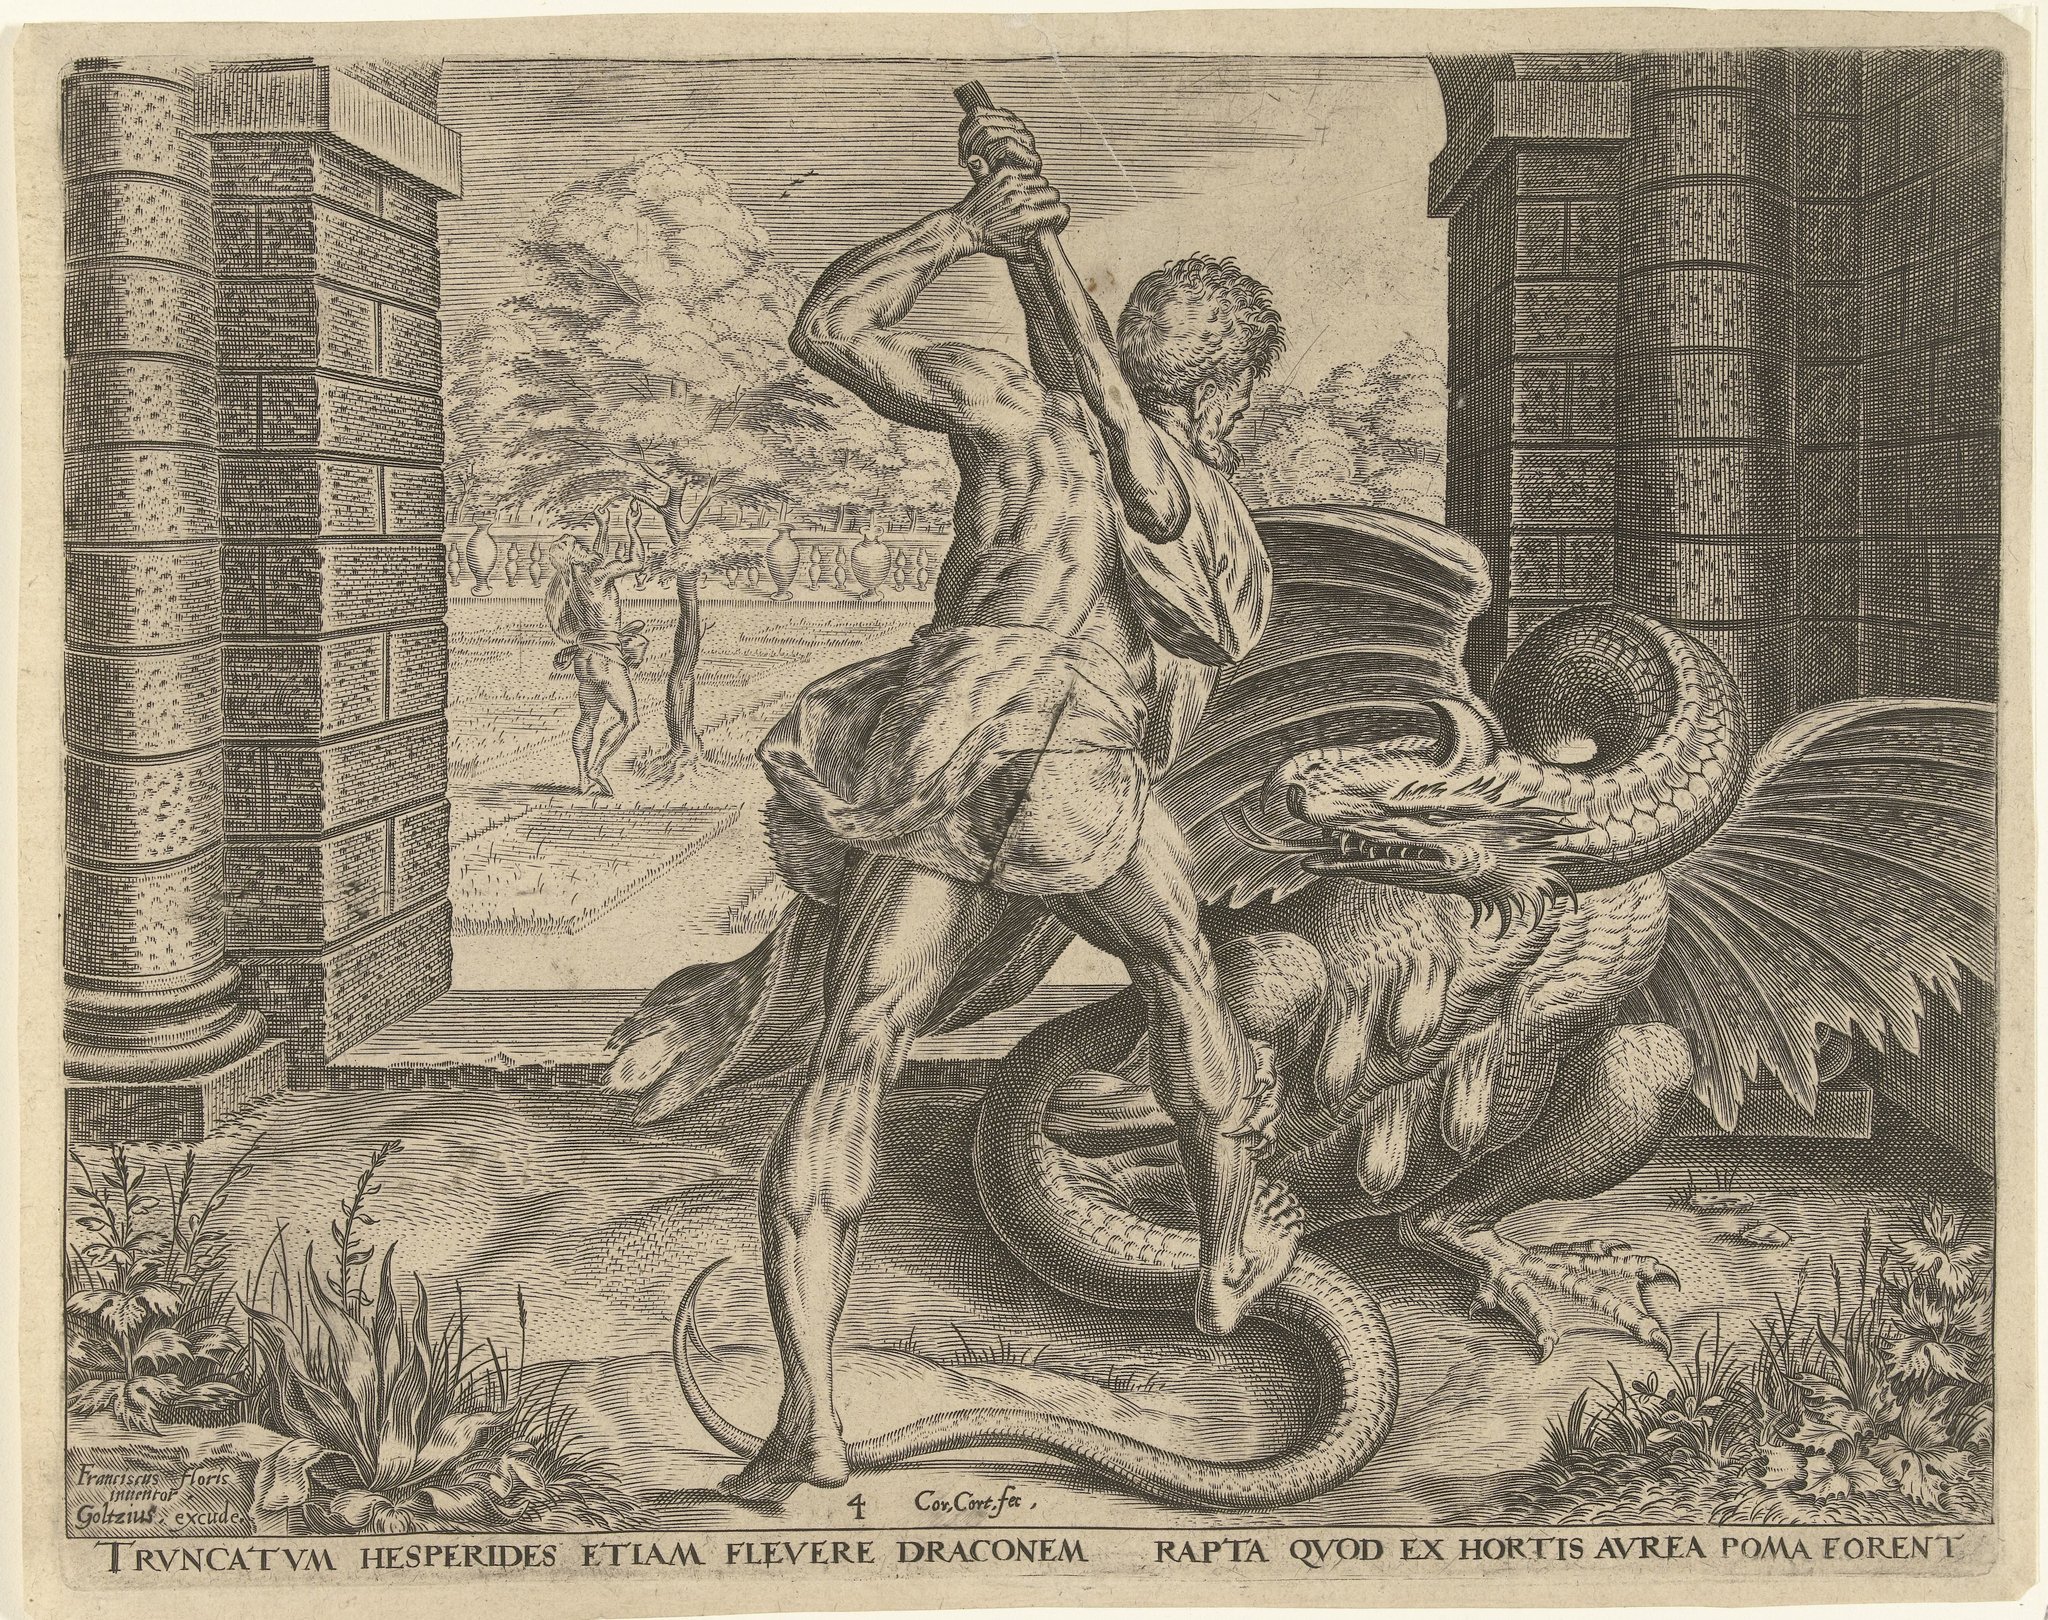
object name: print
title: Werken van Hercules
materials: paper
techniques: engraving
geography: antwerp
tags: the twelve labours of hercules: second series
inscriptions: collector's mark: Lugt 2228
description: Hercules steelt de gouden appelen uit de tuin van de Hesperiden. Met zijn knots verslaat hij de serpent Ladon die de ingang van de tuin bewaakt. Op de achtergrond is hij te zien hoe hij de appelen van de boom plukt.